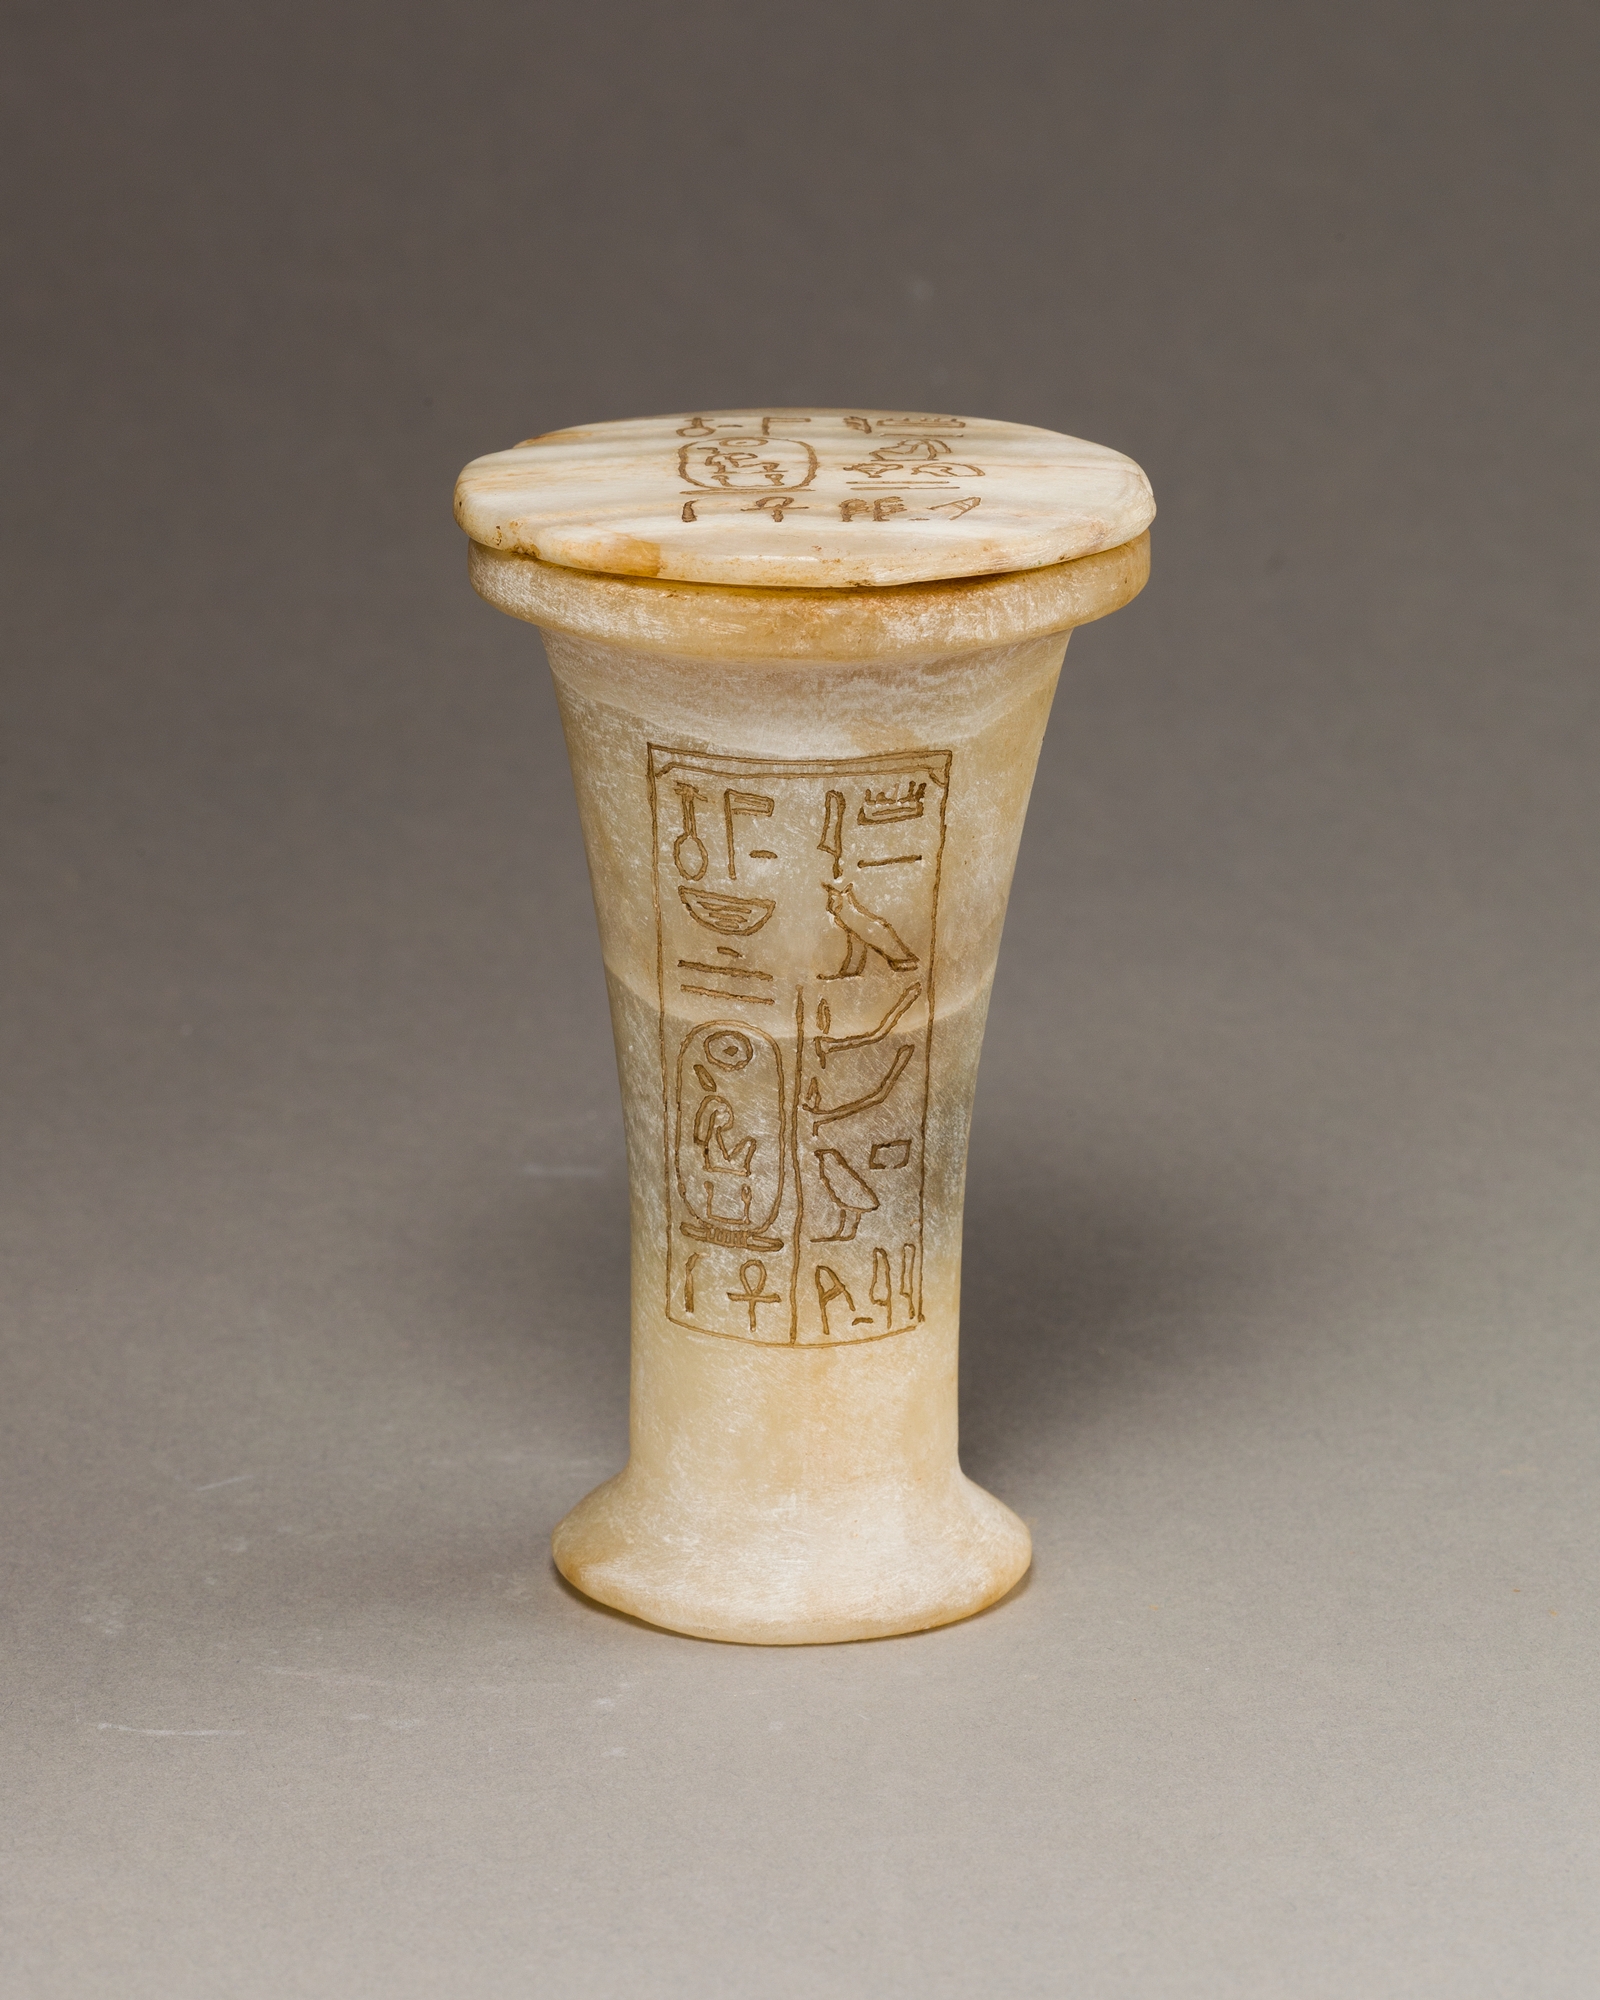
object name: jar, ointment, hatshepsut, maatkare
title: Ointment Jar with Lid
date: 1479-1458 BCE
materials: paint, stone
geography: egypt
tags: hieroglyphs